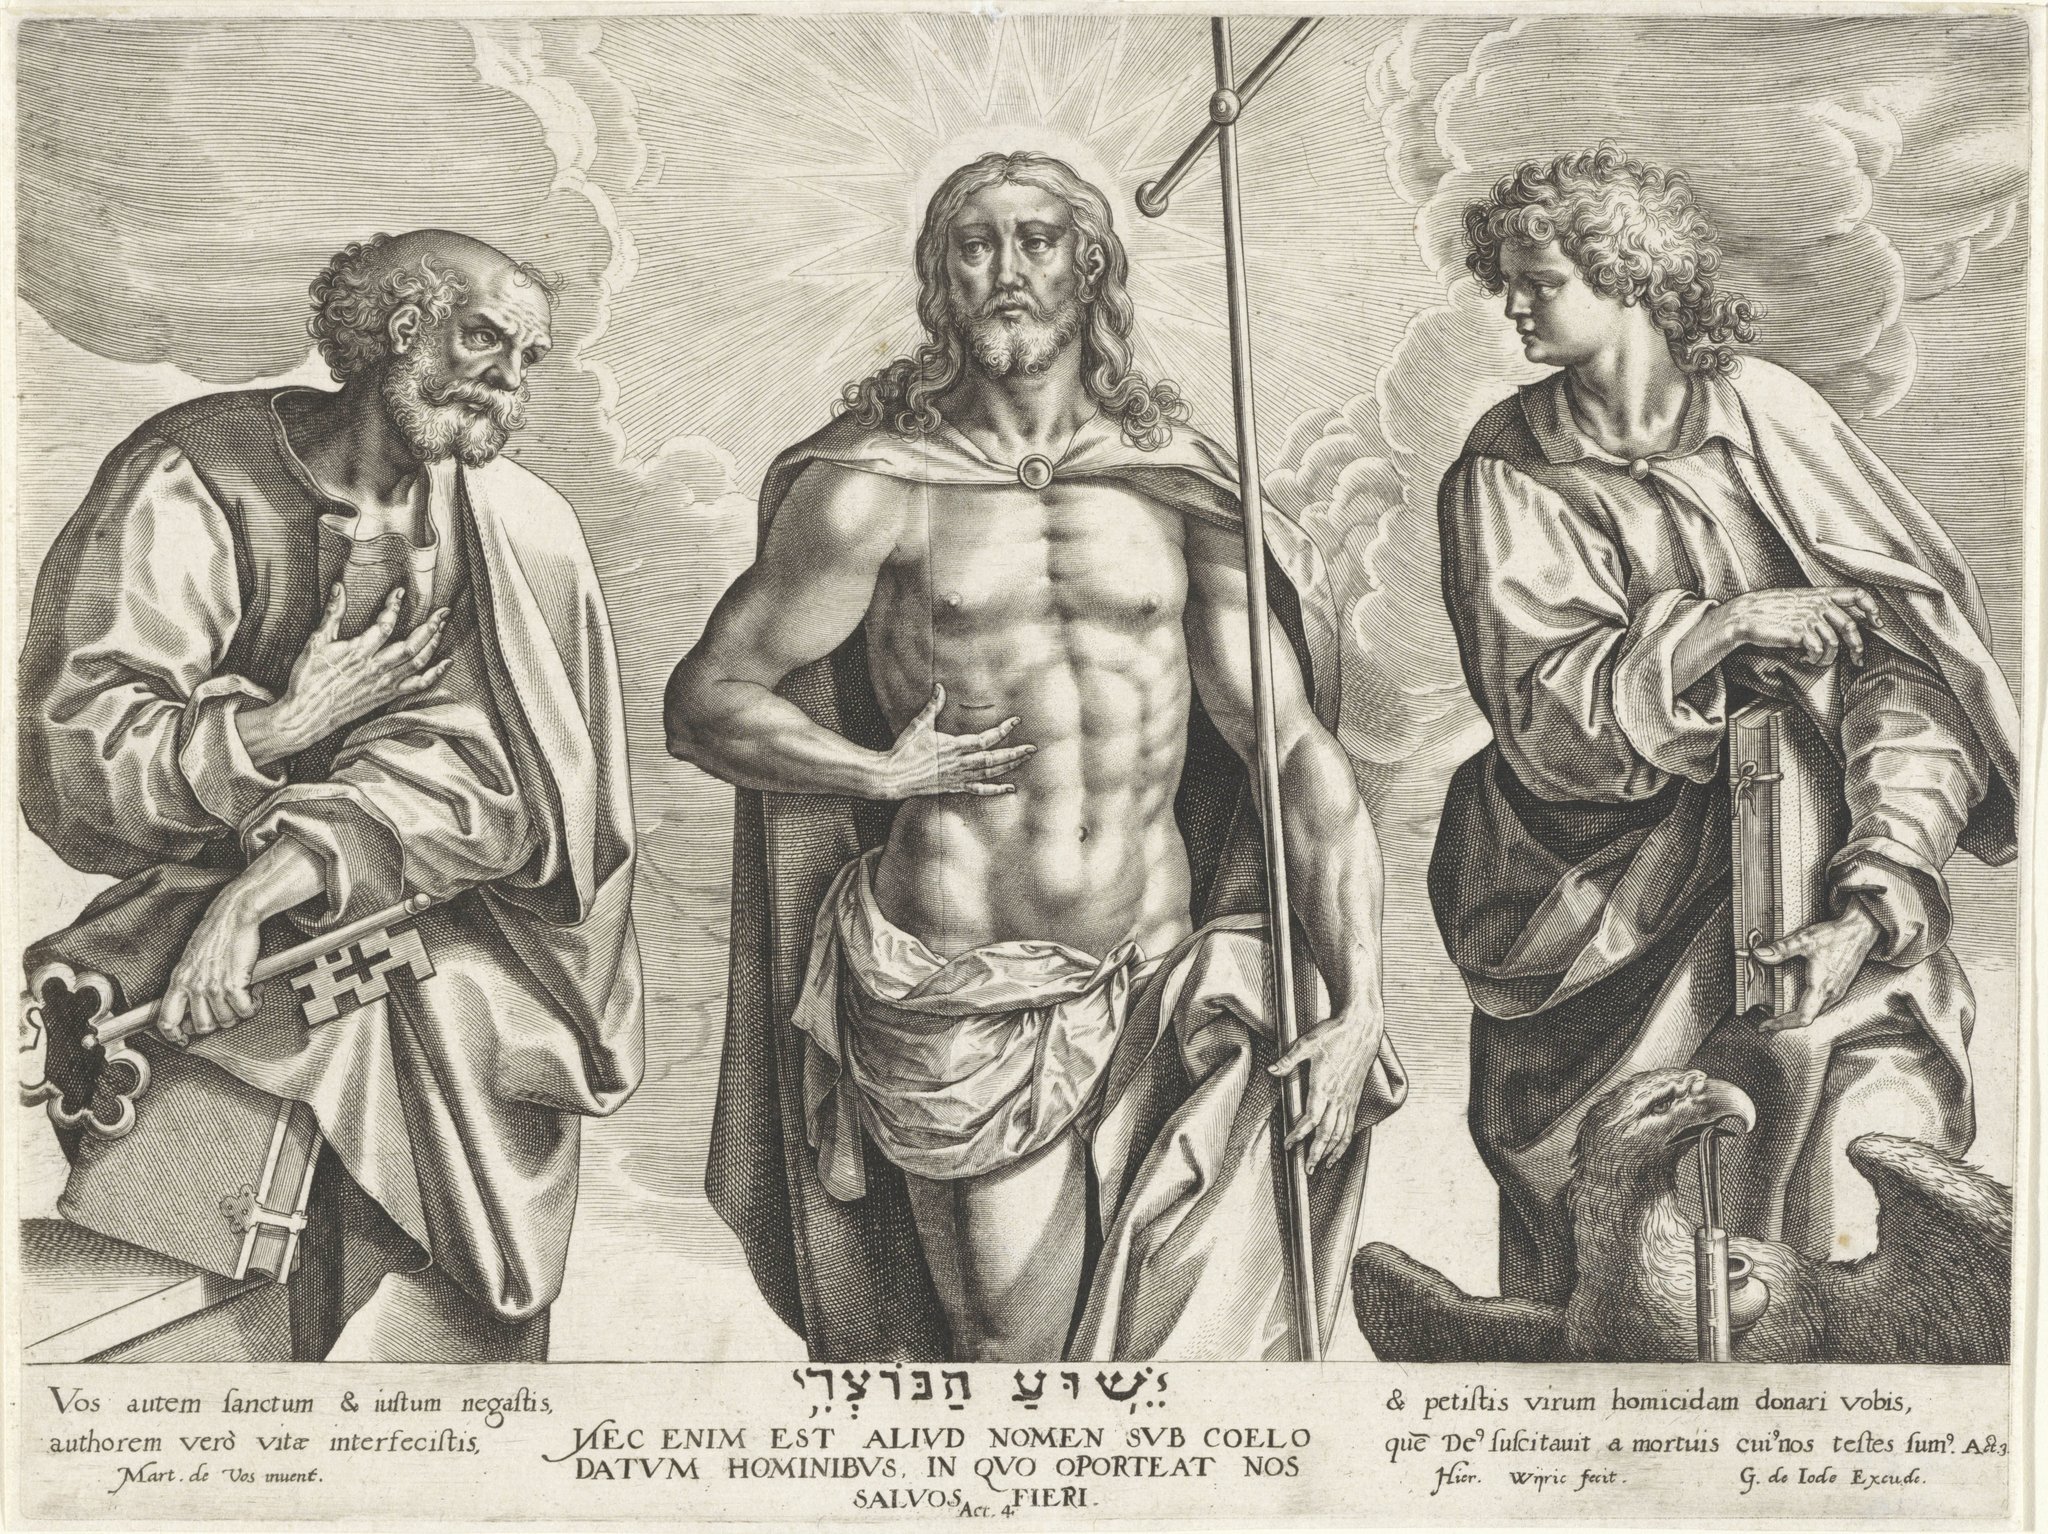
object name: print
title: Herrezen Christus tussen Petrus en Johannes de Evangelist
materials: paper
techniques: engraving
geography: antwerp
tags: the apostle john the evangelist; possible attributes: book, cauldron, chalice with snake, eagle, palm, scroll, the risen christ (with wounds, but without crown of thorns), sometimes holding the cross, the apostle peter, first bishop of rome; possible attributes: book, cock, (upturned) cross, (triple) crozier, fish, key, scroll, ship, tiara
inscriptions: collector's mark: Lugt 2228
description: De herrezen Christus toont de kruiswond in zijn zijde. Hij staat tussen de H. Petrus (met sleutel) en de H. Johannes(met adelaar). In de marge een titel in het Hebreeuws, een drieregelig Bijbelcitaat uit Hand. 4 en een vierregelig Bijbelcitaat uit Hand. 3, in twee kolommen, in het Latijn.